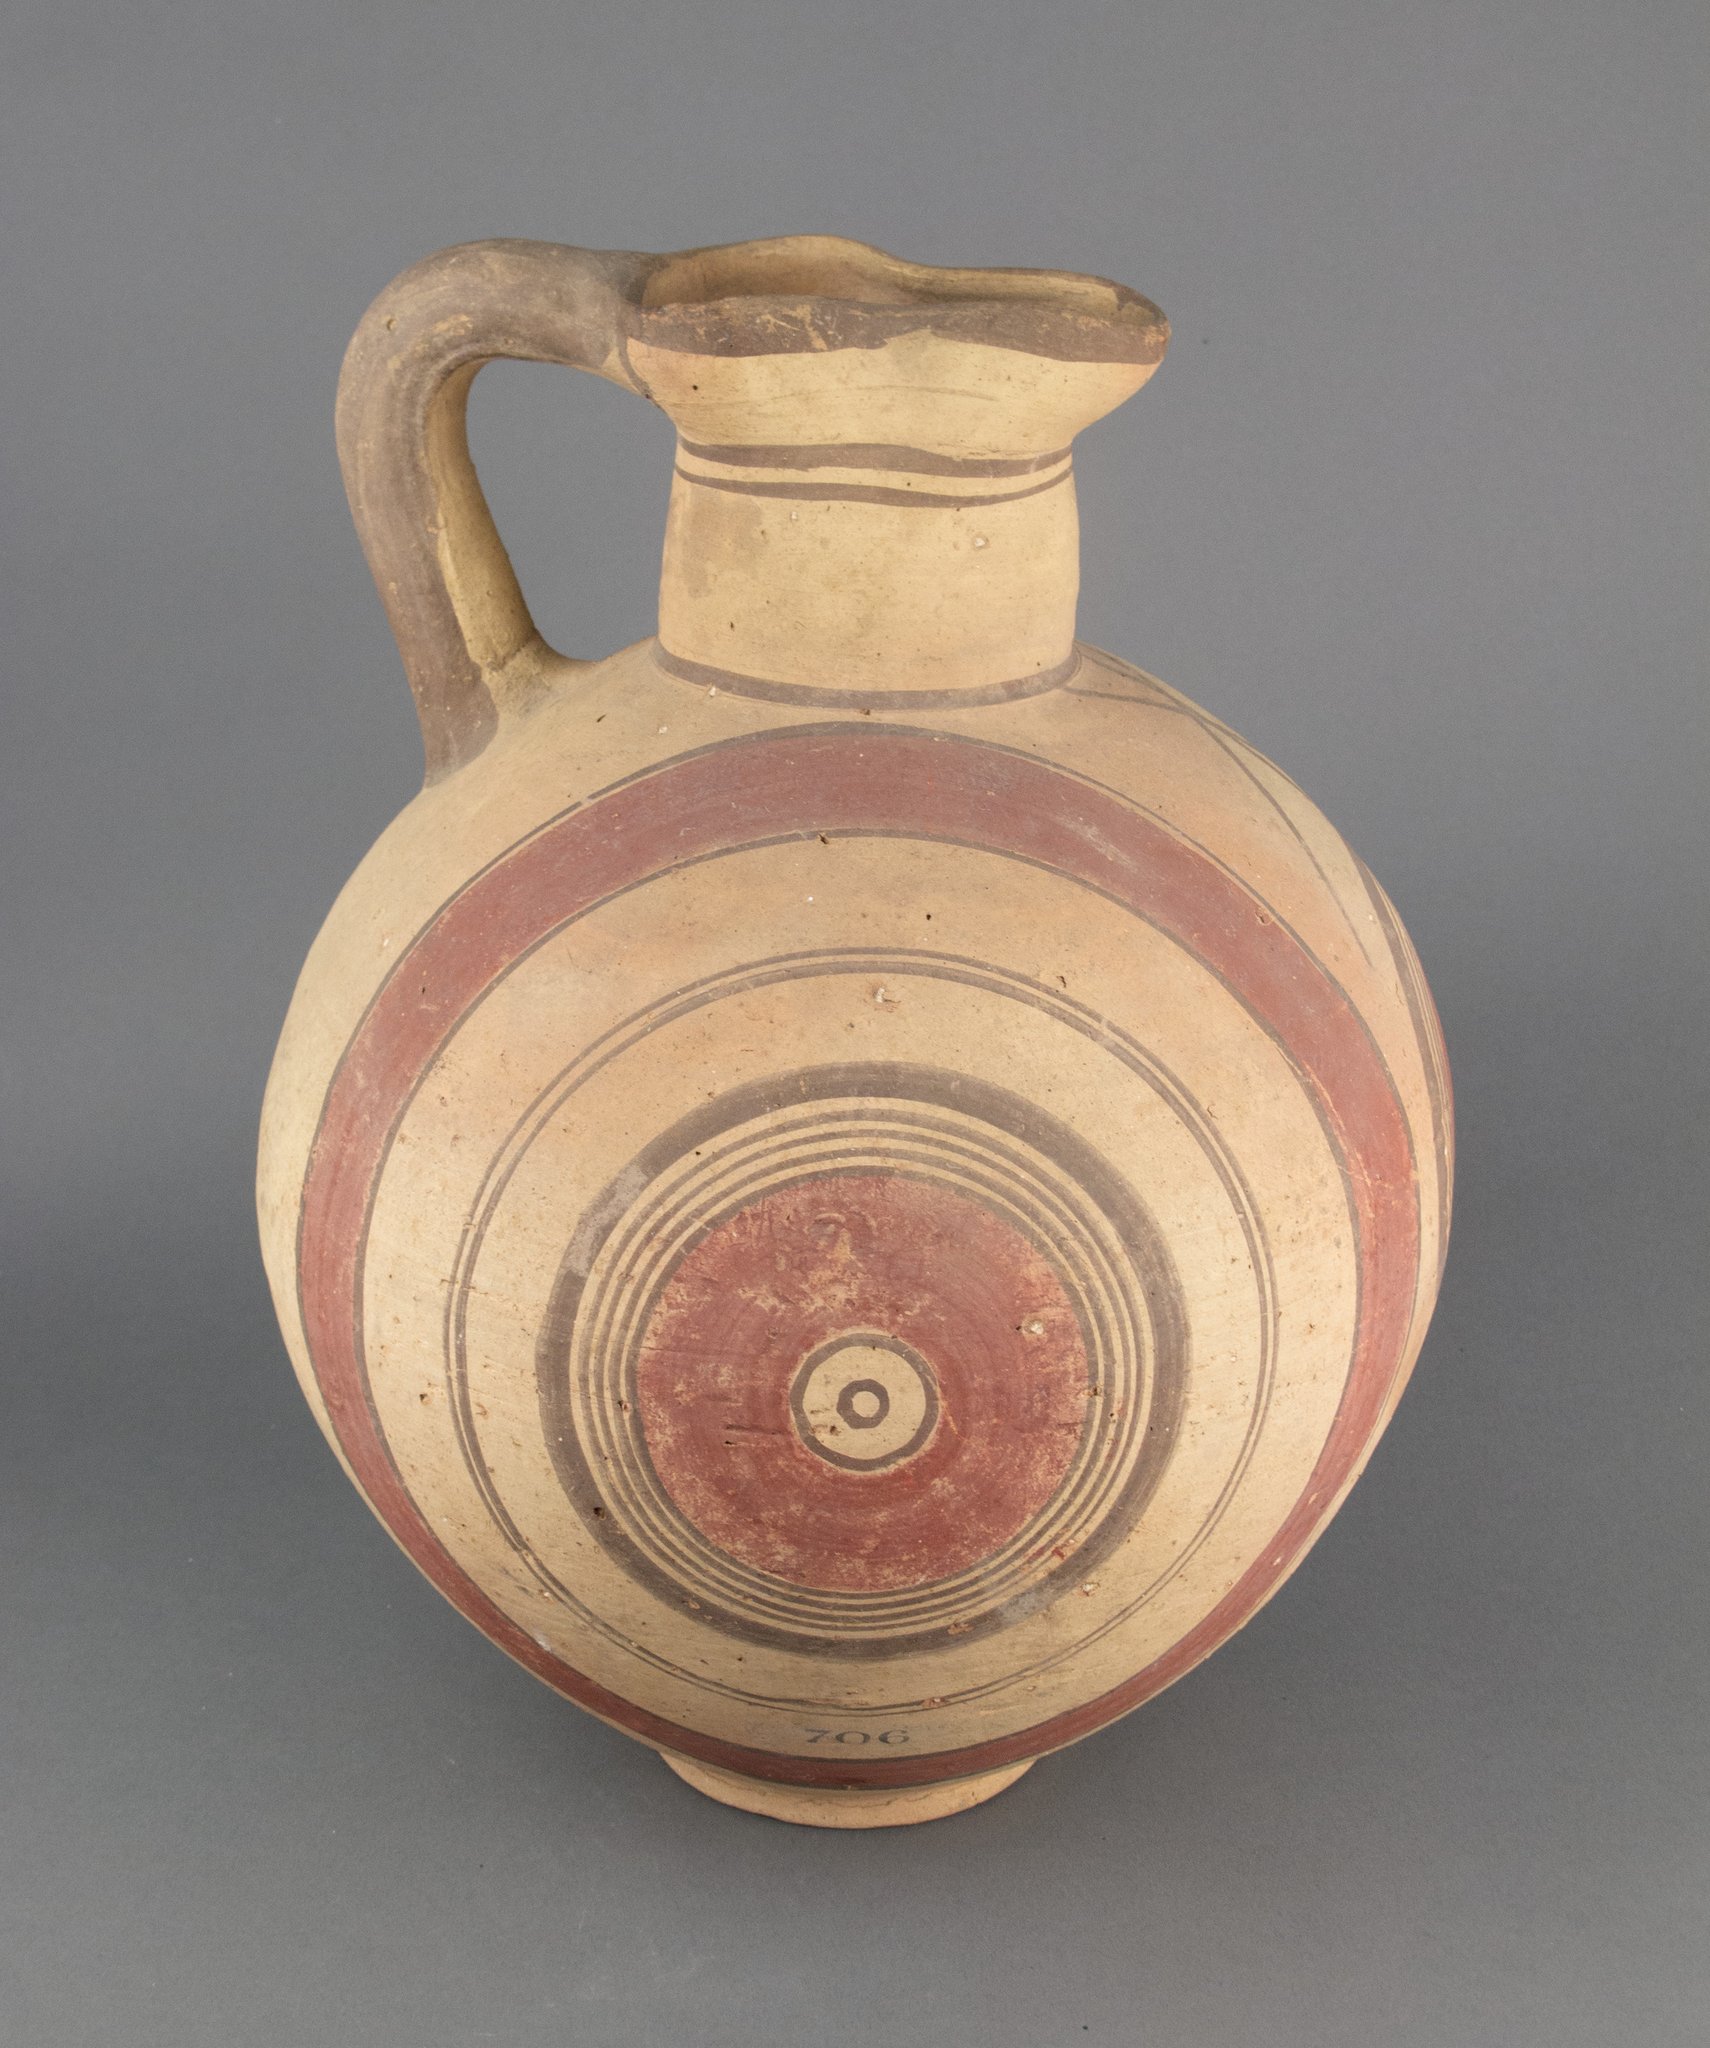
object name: jug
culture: cypriot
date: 750-600 BCE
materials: terracotta